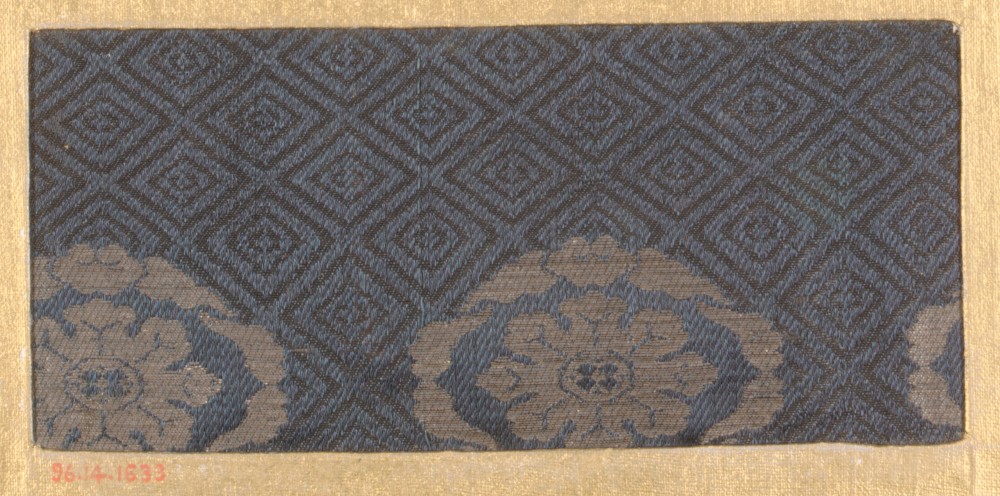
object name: piece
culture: japanese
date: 1701-1900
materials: silk